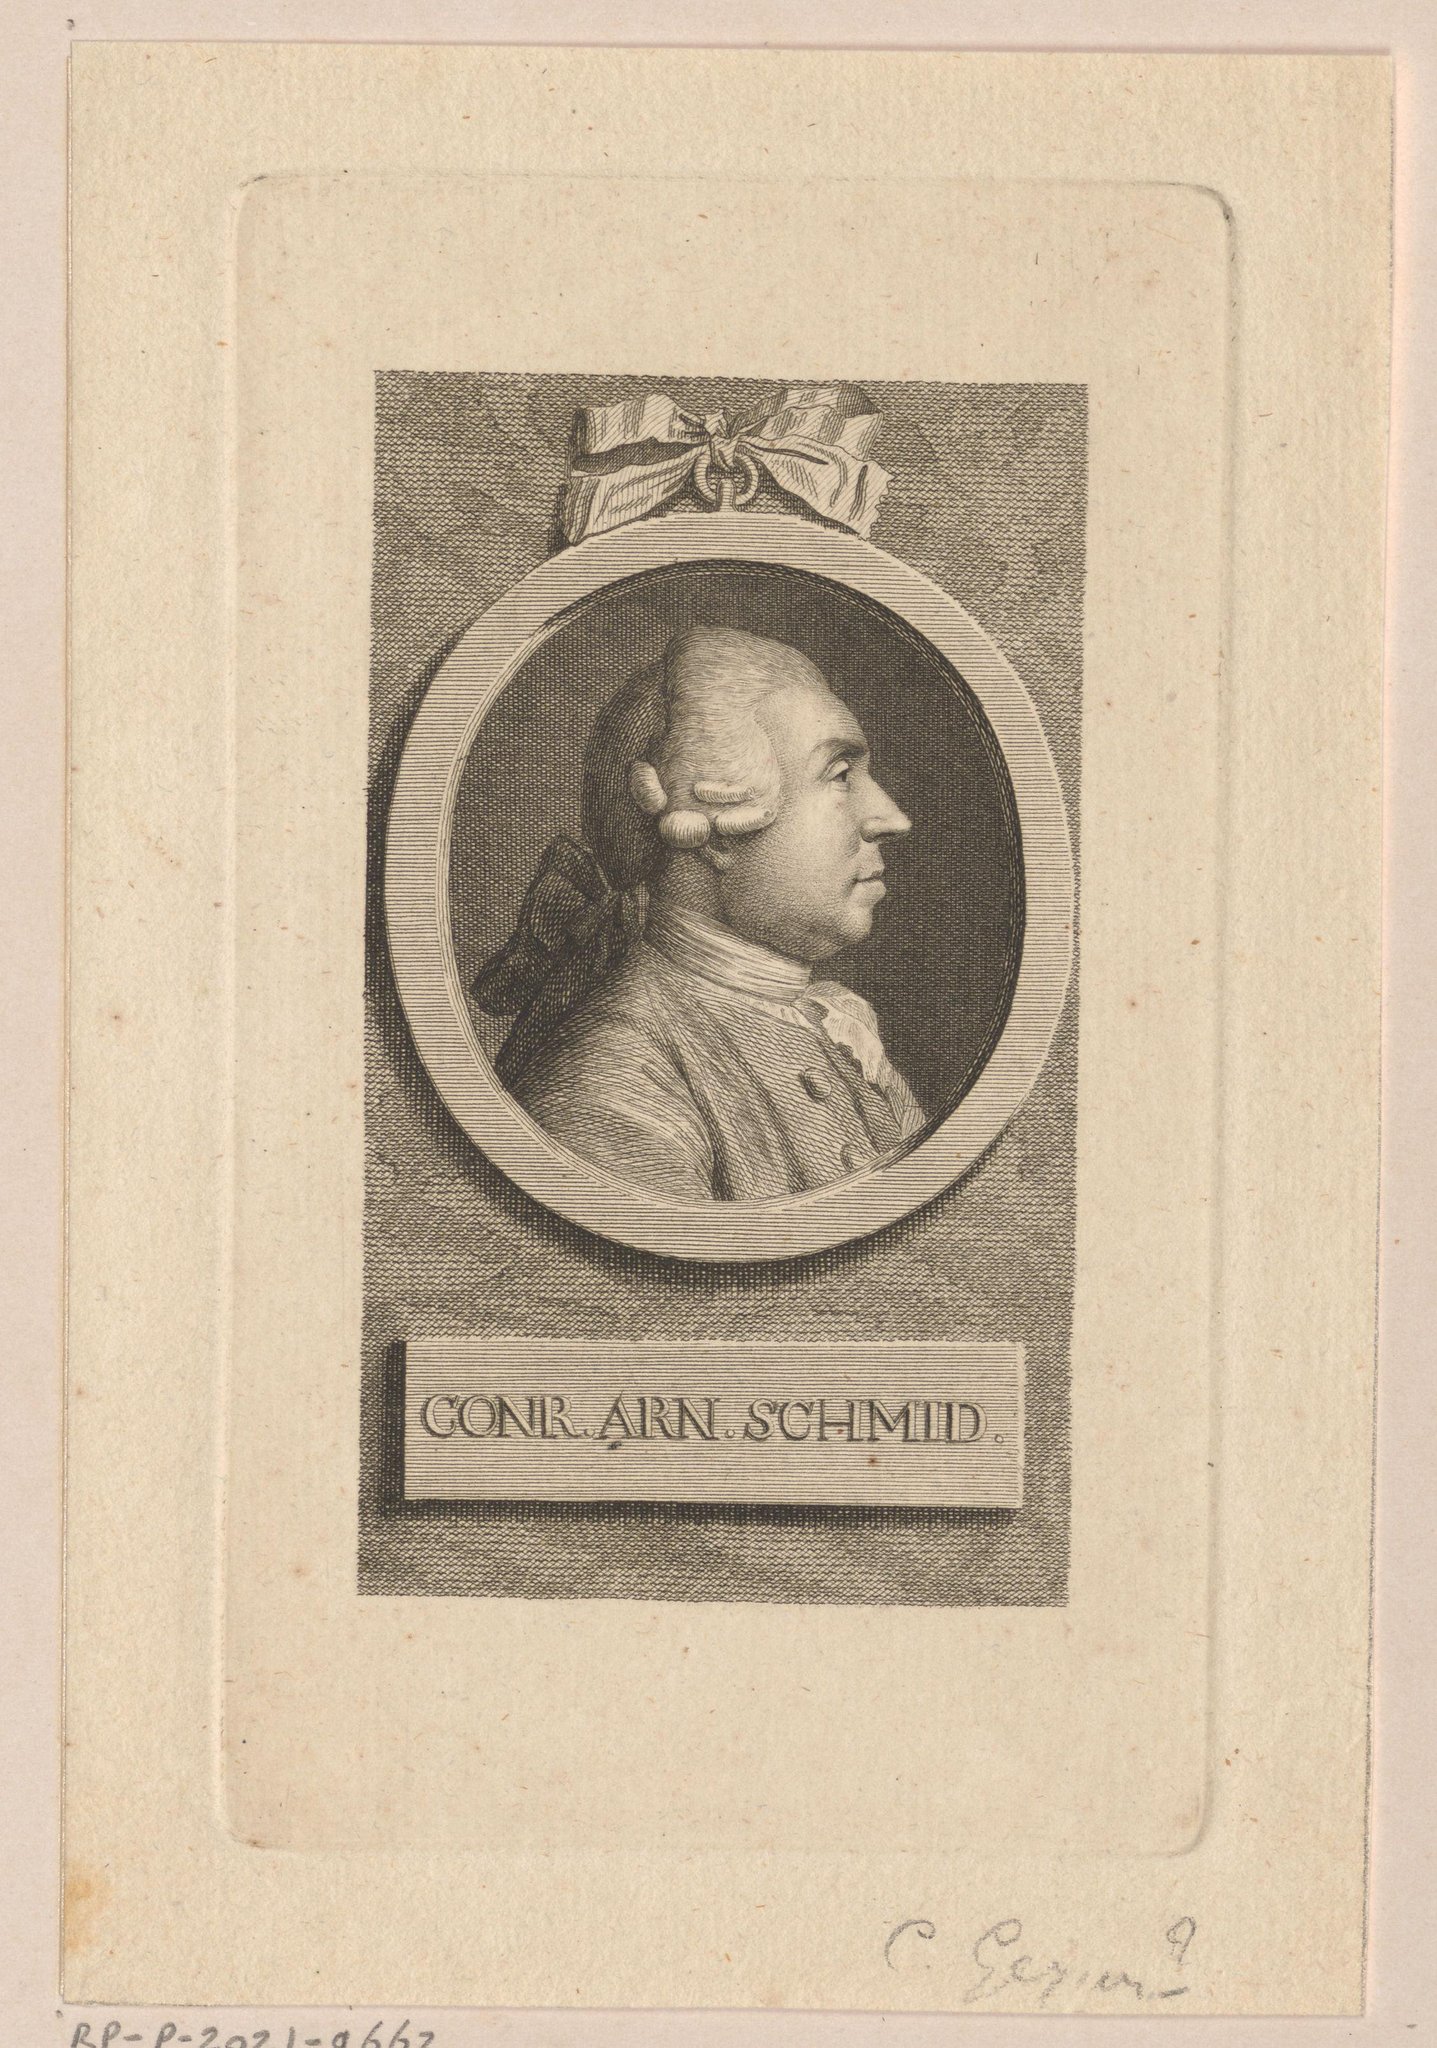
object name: print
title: Portret van Konrad Arnold Schmid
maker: christian gottlieb geyser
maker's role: print maker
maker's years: 1742-1803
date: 1777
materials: paper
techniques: engraving, etching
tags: philology, historical persons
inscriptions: collector's mark: Lugt 2228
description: Prent waarschijnlijk uit: Dyk, Johann Gottfried. Almanach der Deutschen Musen. Leipzig: Beygandschen Buchhandlung, 1777.